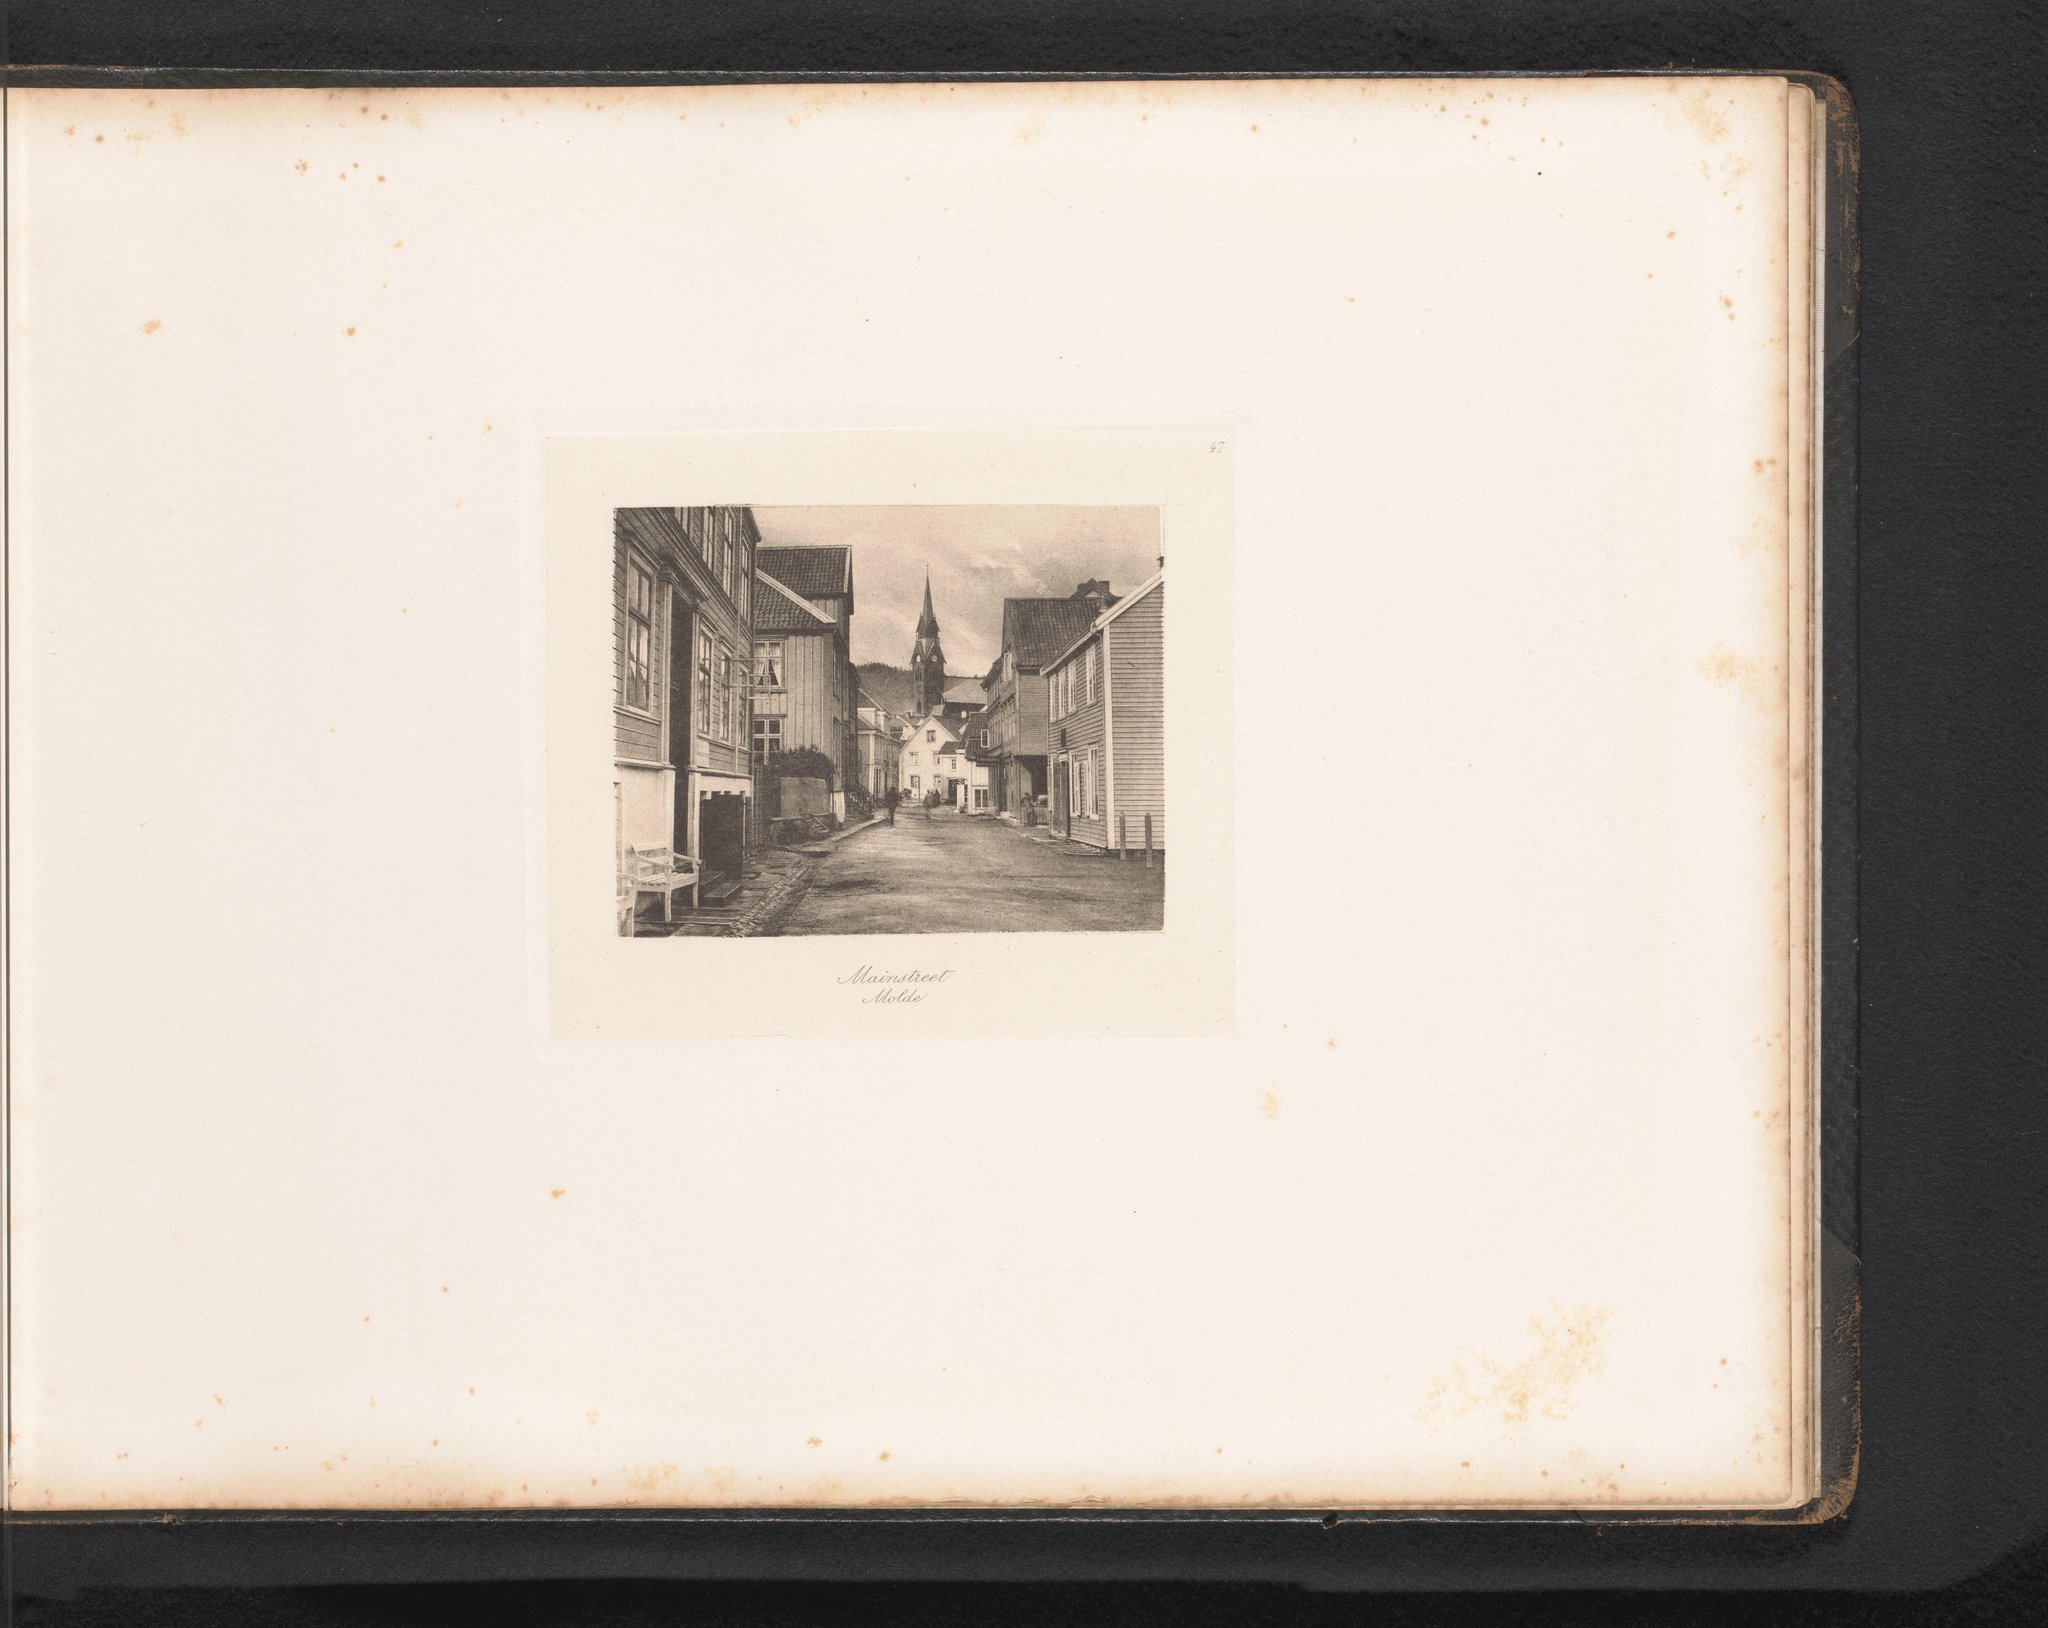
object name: photomechanical print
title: Mainstreet, Molde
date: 1888-1893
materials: paper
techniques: photograph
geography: vienna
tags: church (exterior), street (+ city(-scape) with figures, staffage)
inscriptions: number: ‘47’